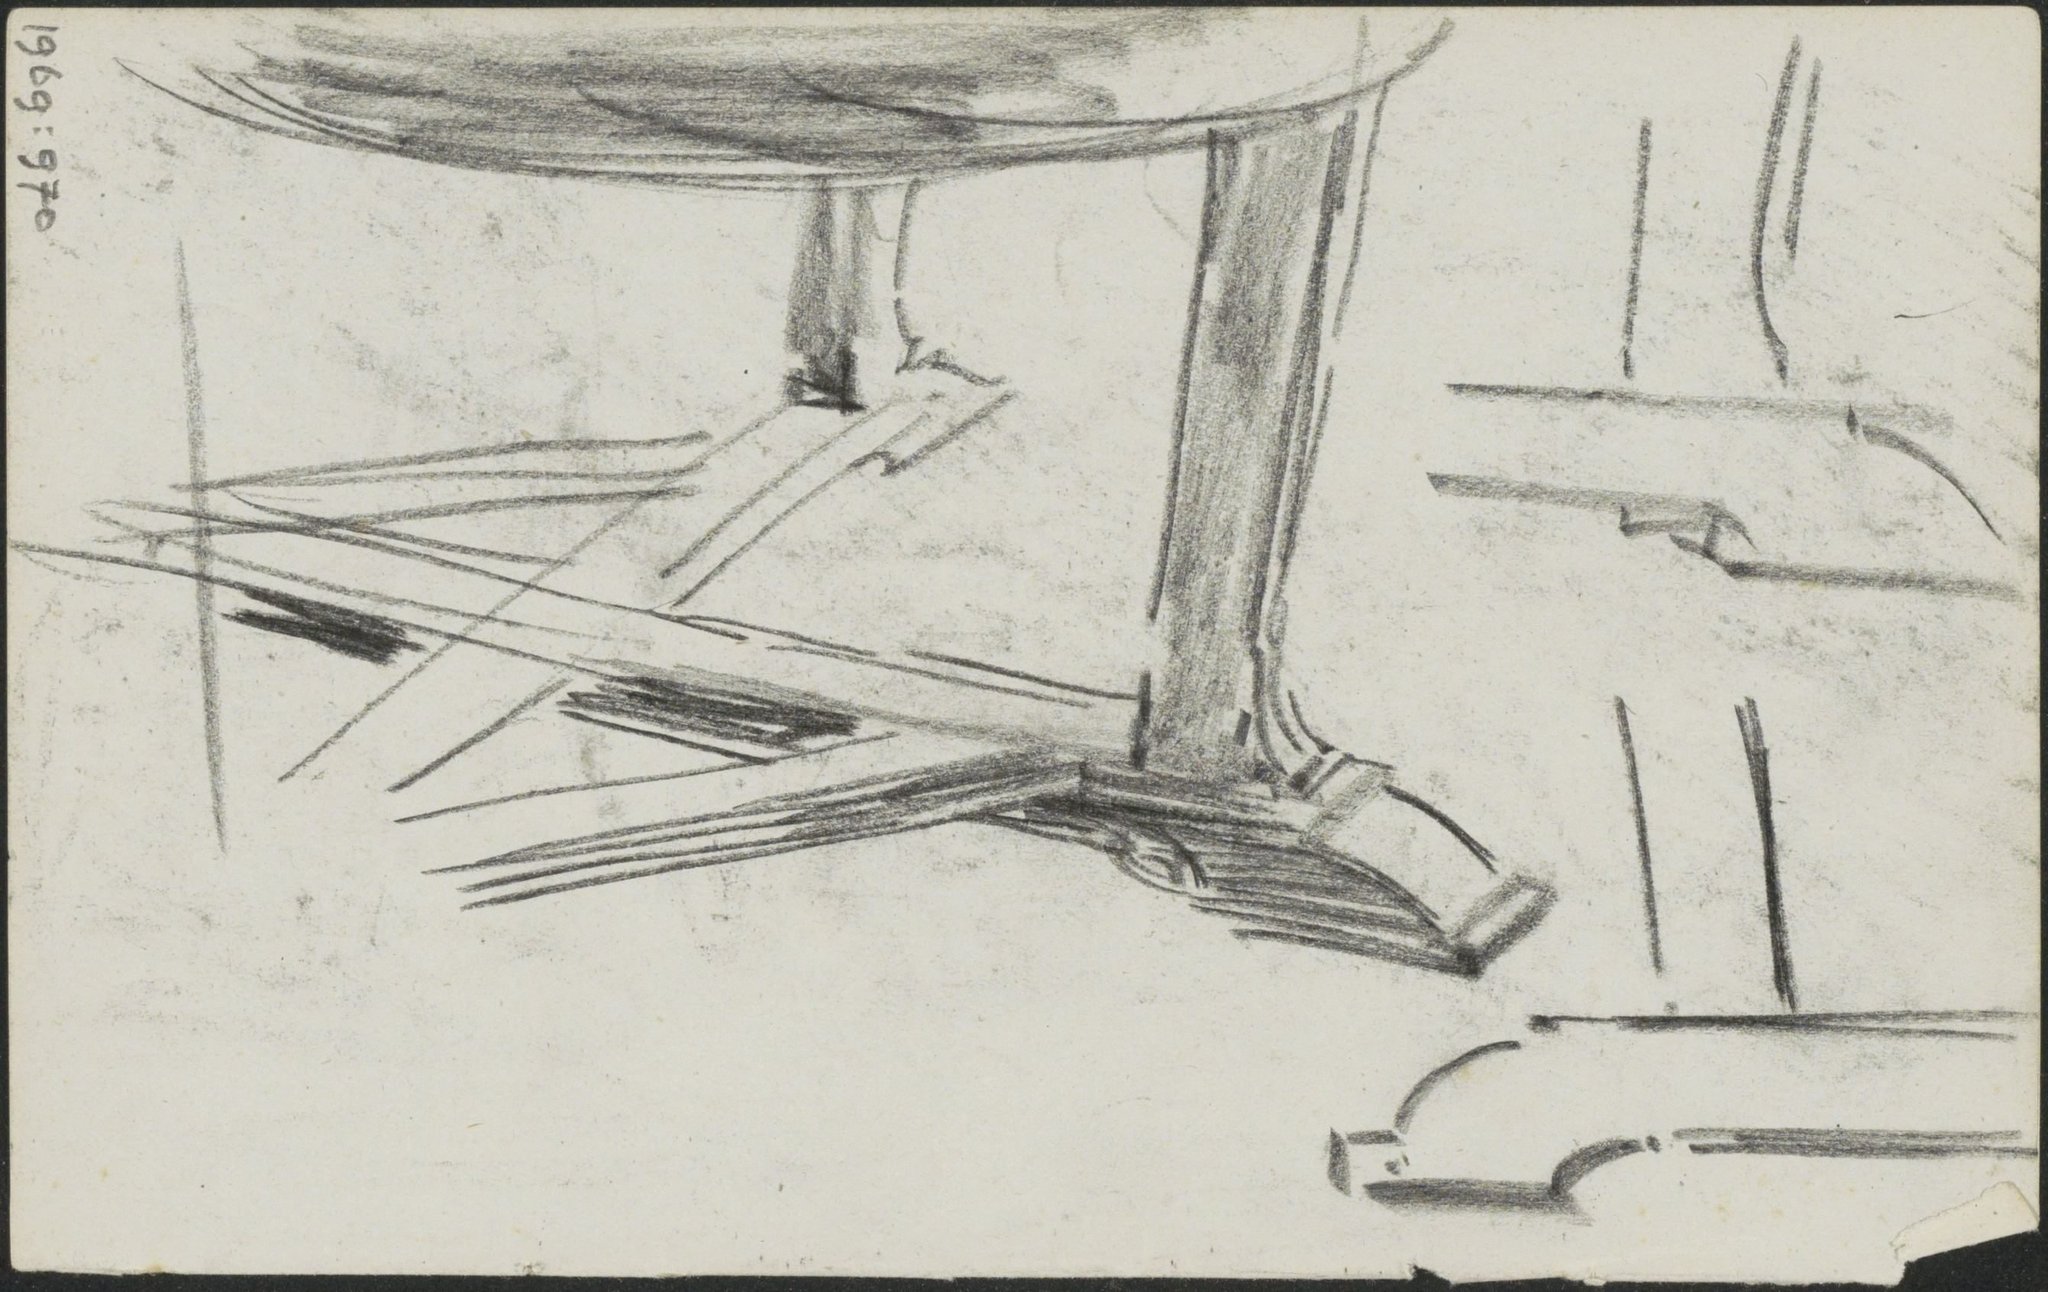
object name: drawing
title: Onderstel van een tafel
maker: gerrit willem dijsselhof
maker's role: designer, draughtsman, print maker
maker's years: 1866-1924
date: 1876-1924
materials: chalk, paper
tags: table